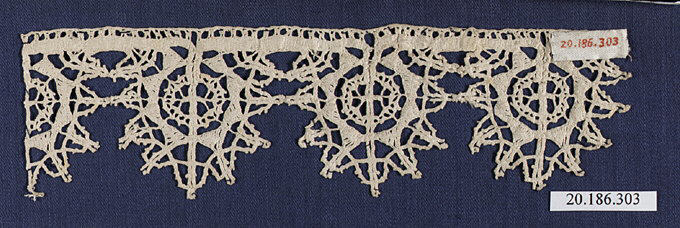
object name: edging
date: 1601-1700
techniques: lace